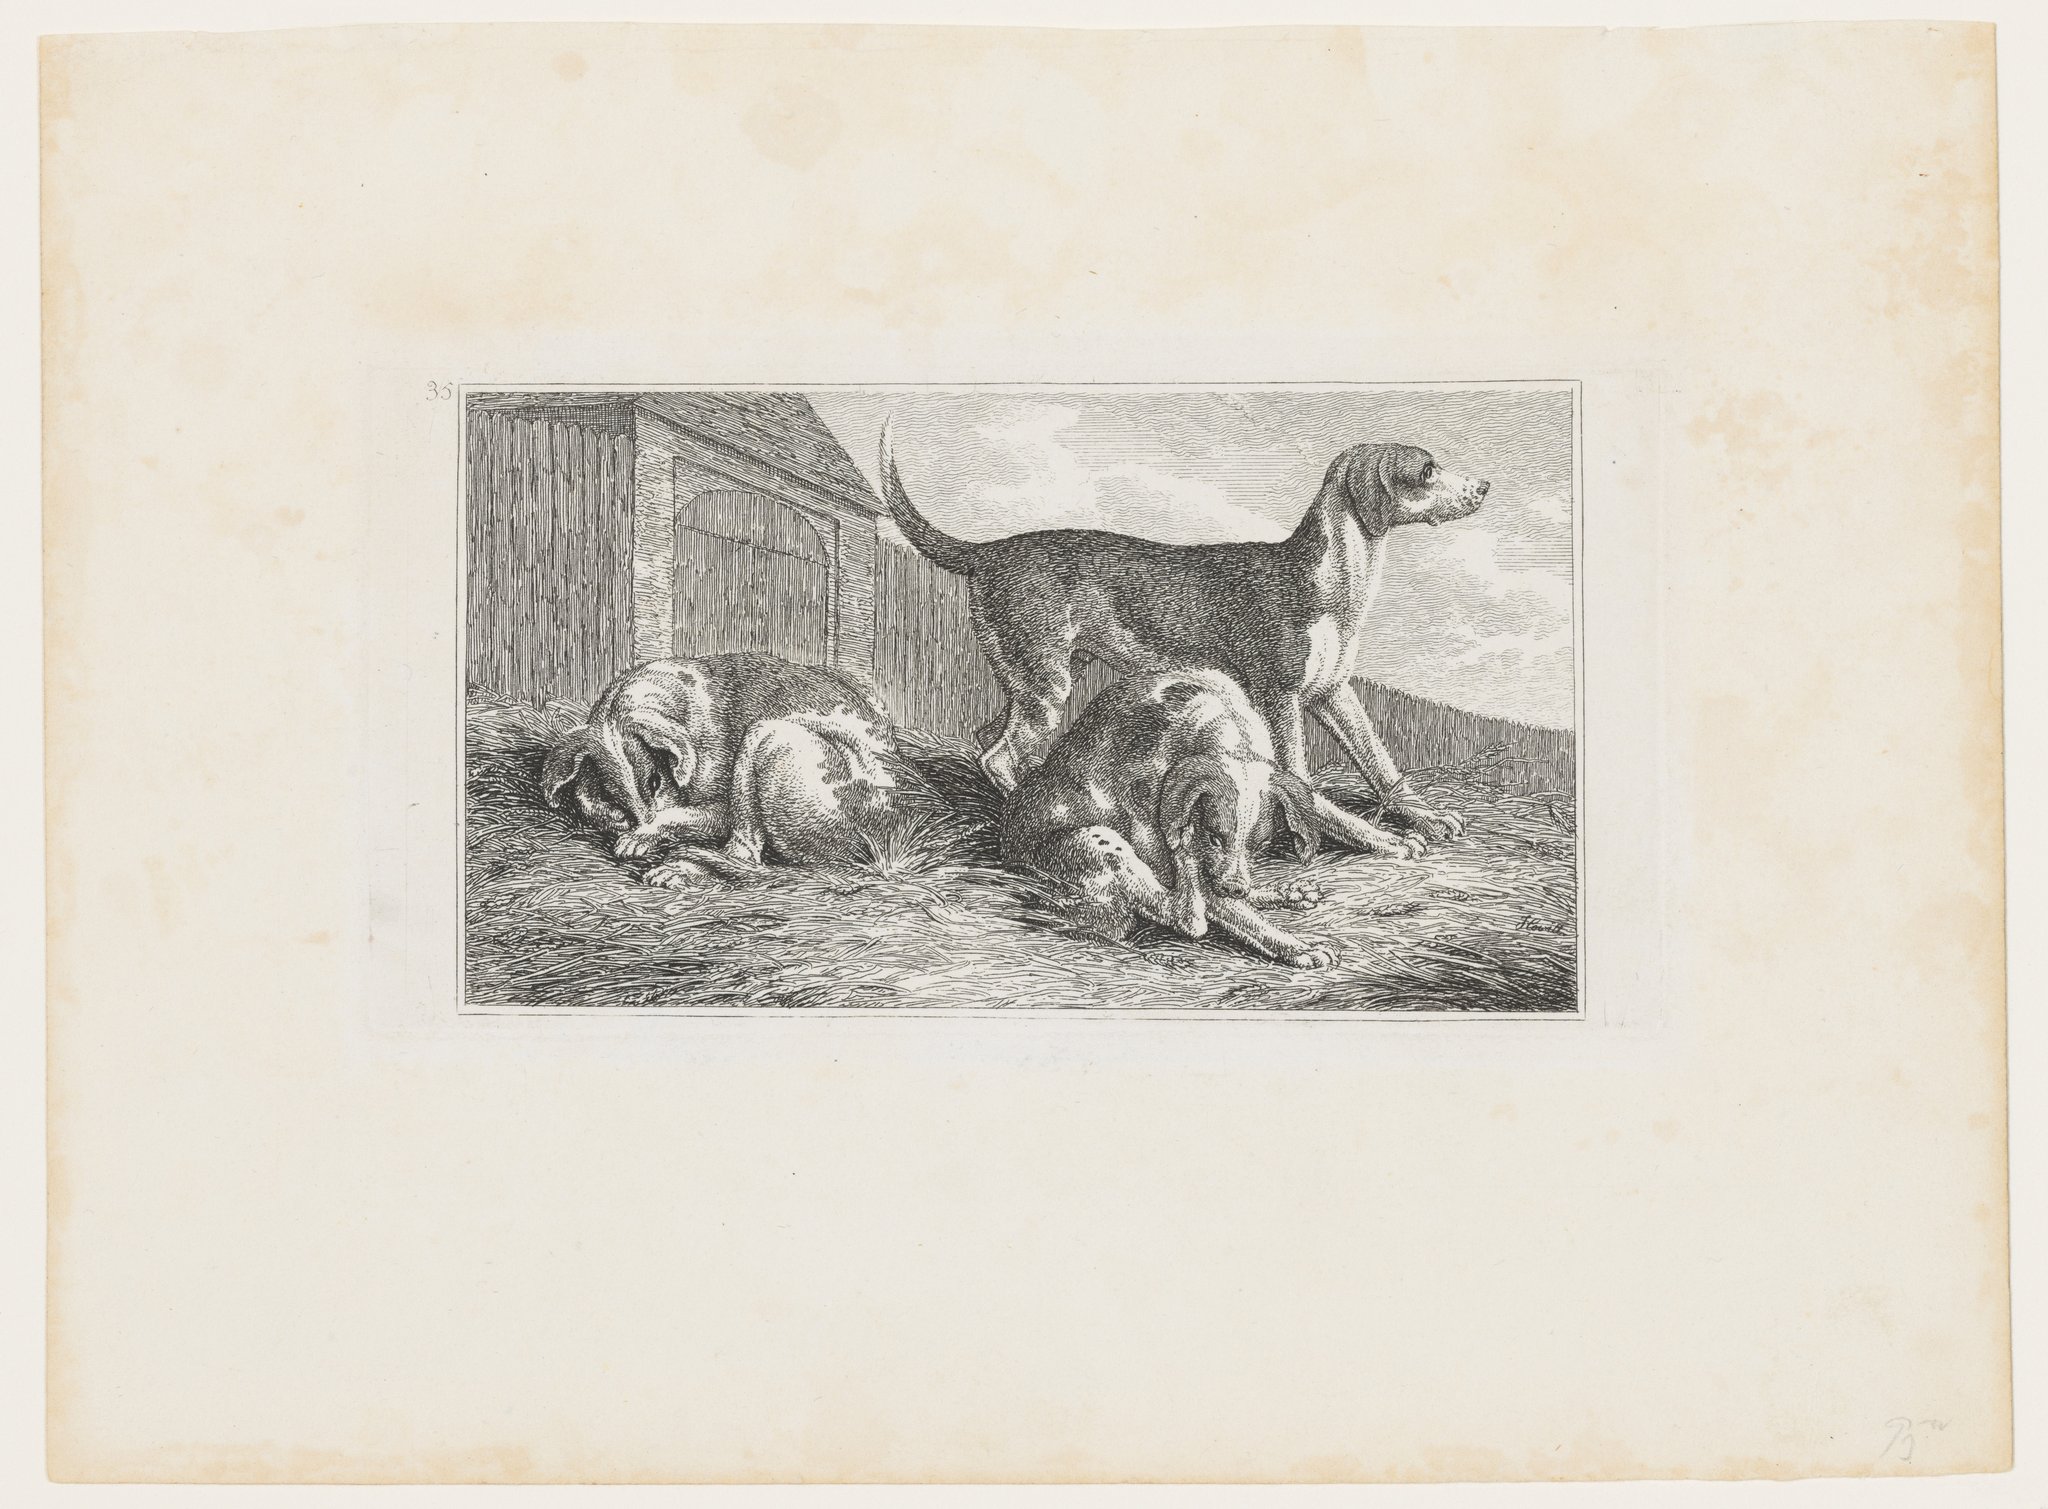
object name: print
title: Dogs Playing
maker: samuel howitt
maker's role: artist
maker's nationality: british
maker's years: 1756-1823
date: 1810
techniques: engraving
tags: dogs